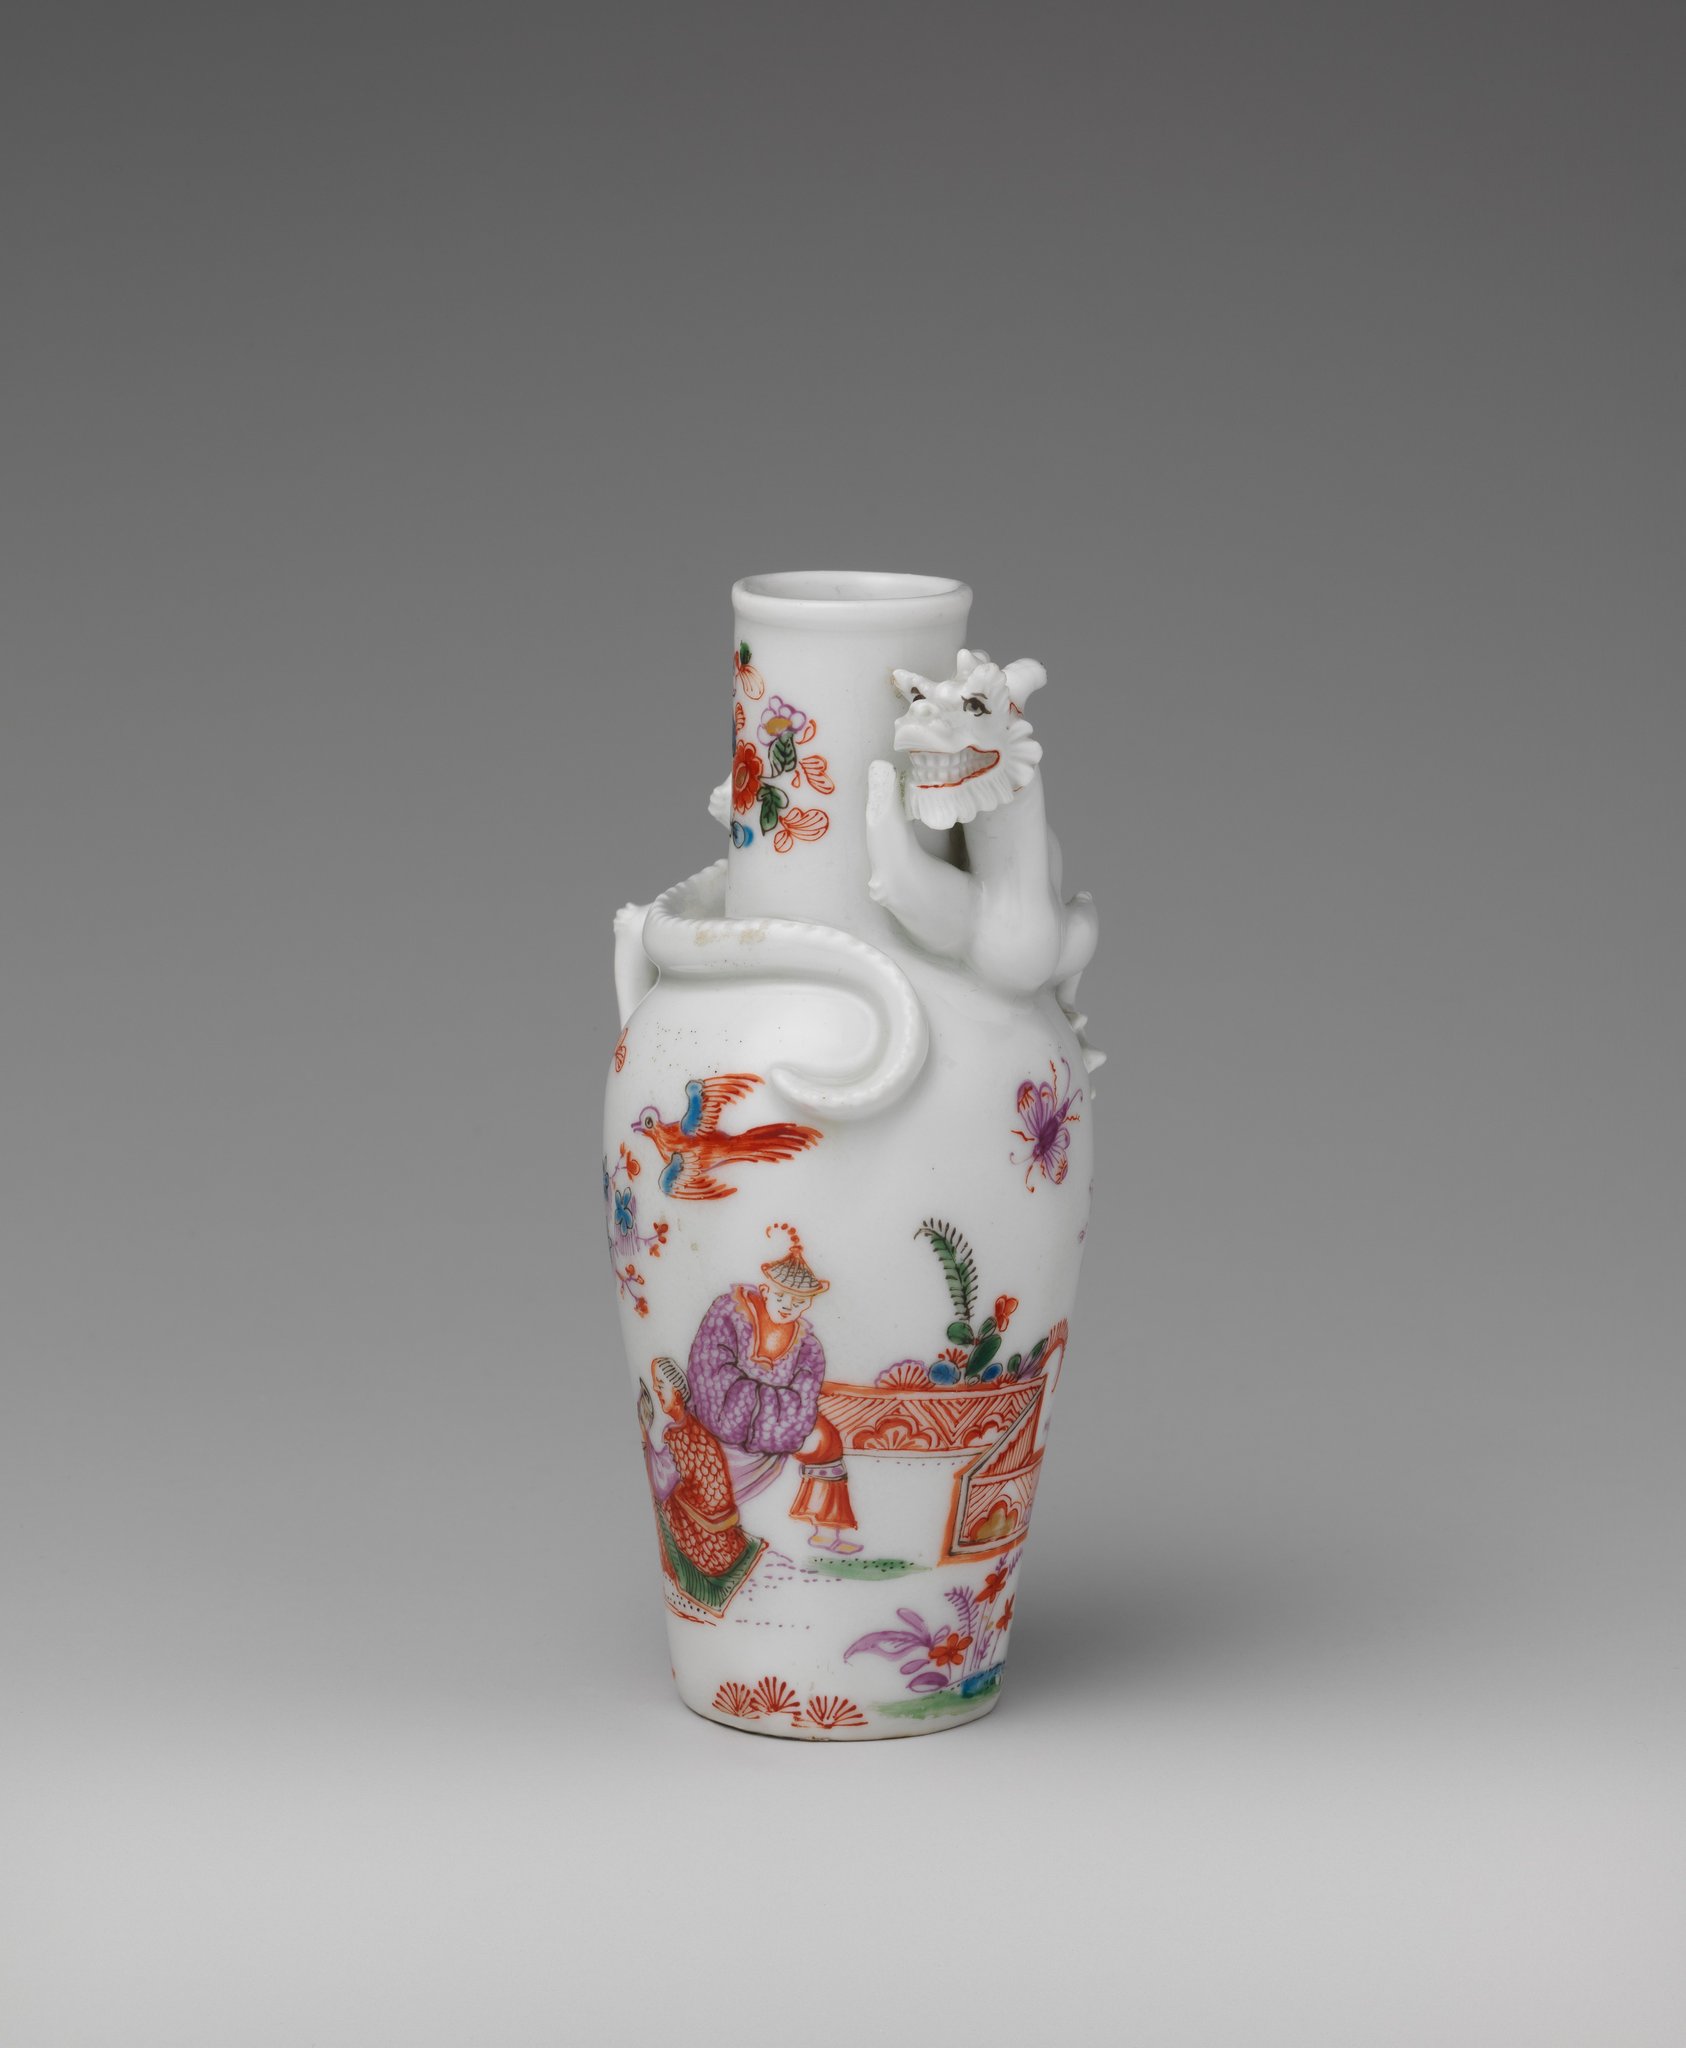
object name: vase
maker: vienna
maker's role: manufactory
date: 1725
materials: hard paste porcelain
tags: birds,men,dragons,flowers